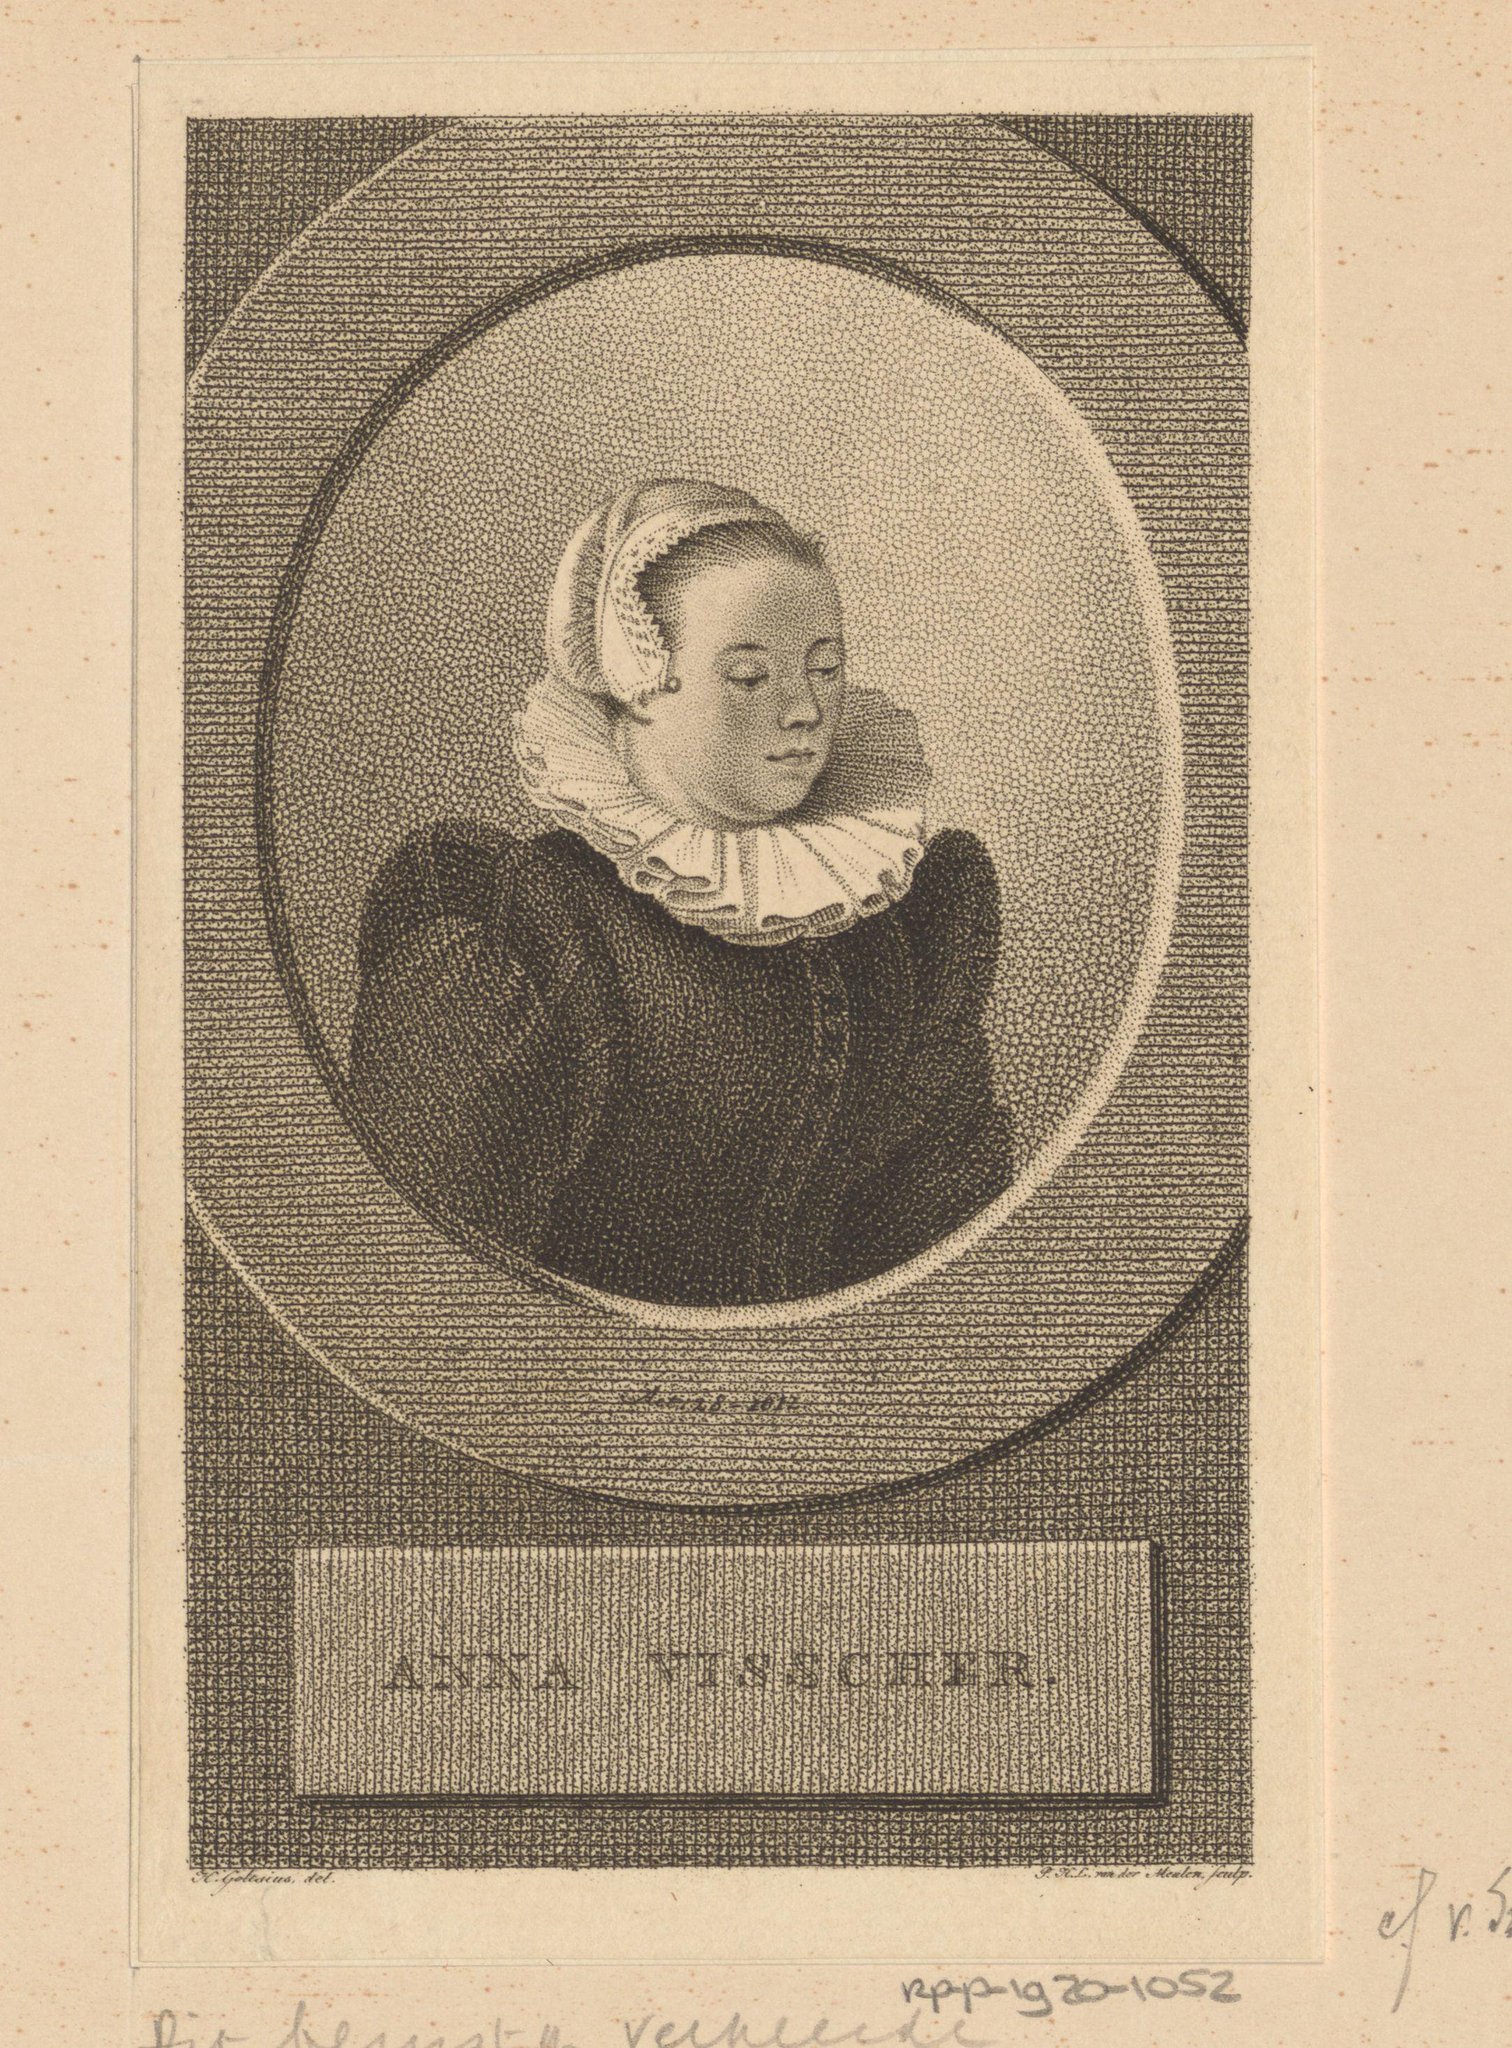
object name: print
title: Portret van een onbekende vrouw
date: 1808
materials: paper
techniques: etching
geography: northern netherlands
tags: anna roemers visscher, anonymous historical person portrayed alone - bb - woman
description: Prent waarschijnlijk uit: Scheltema, Jacobus. Anna en Maria Tesselschade, de dochters van Roemer Visscher. Amsterdam: J.W. Ijntema en Comp., 1808.